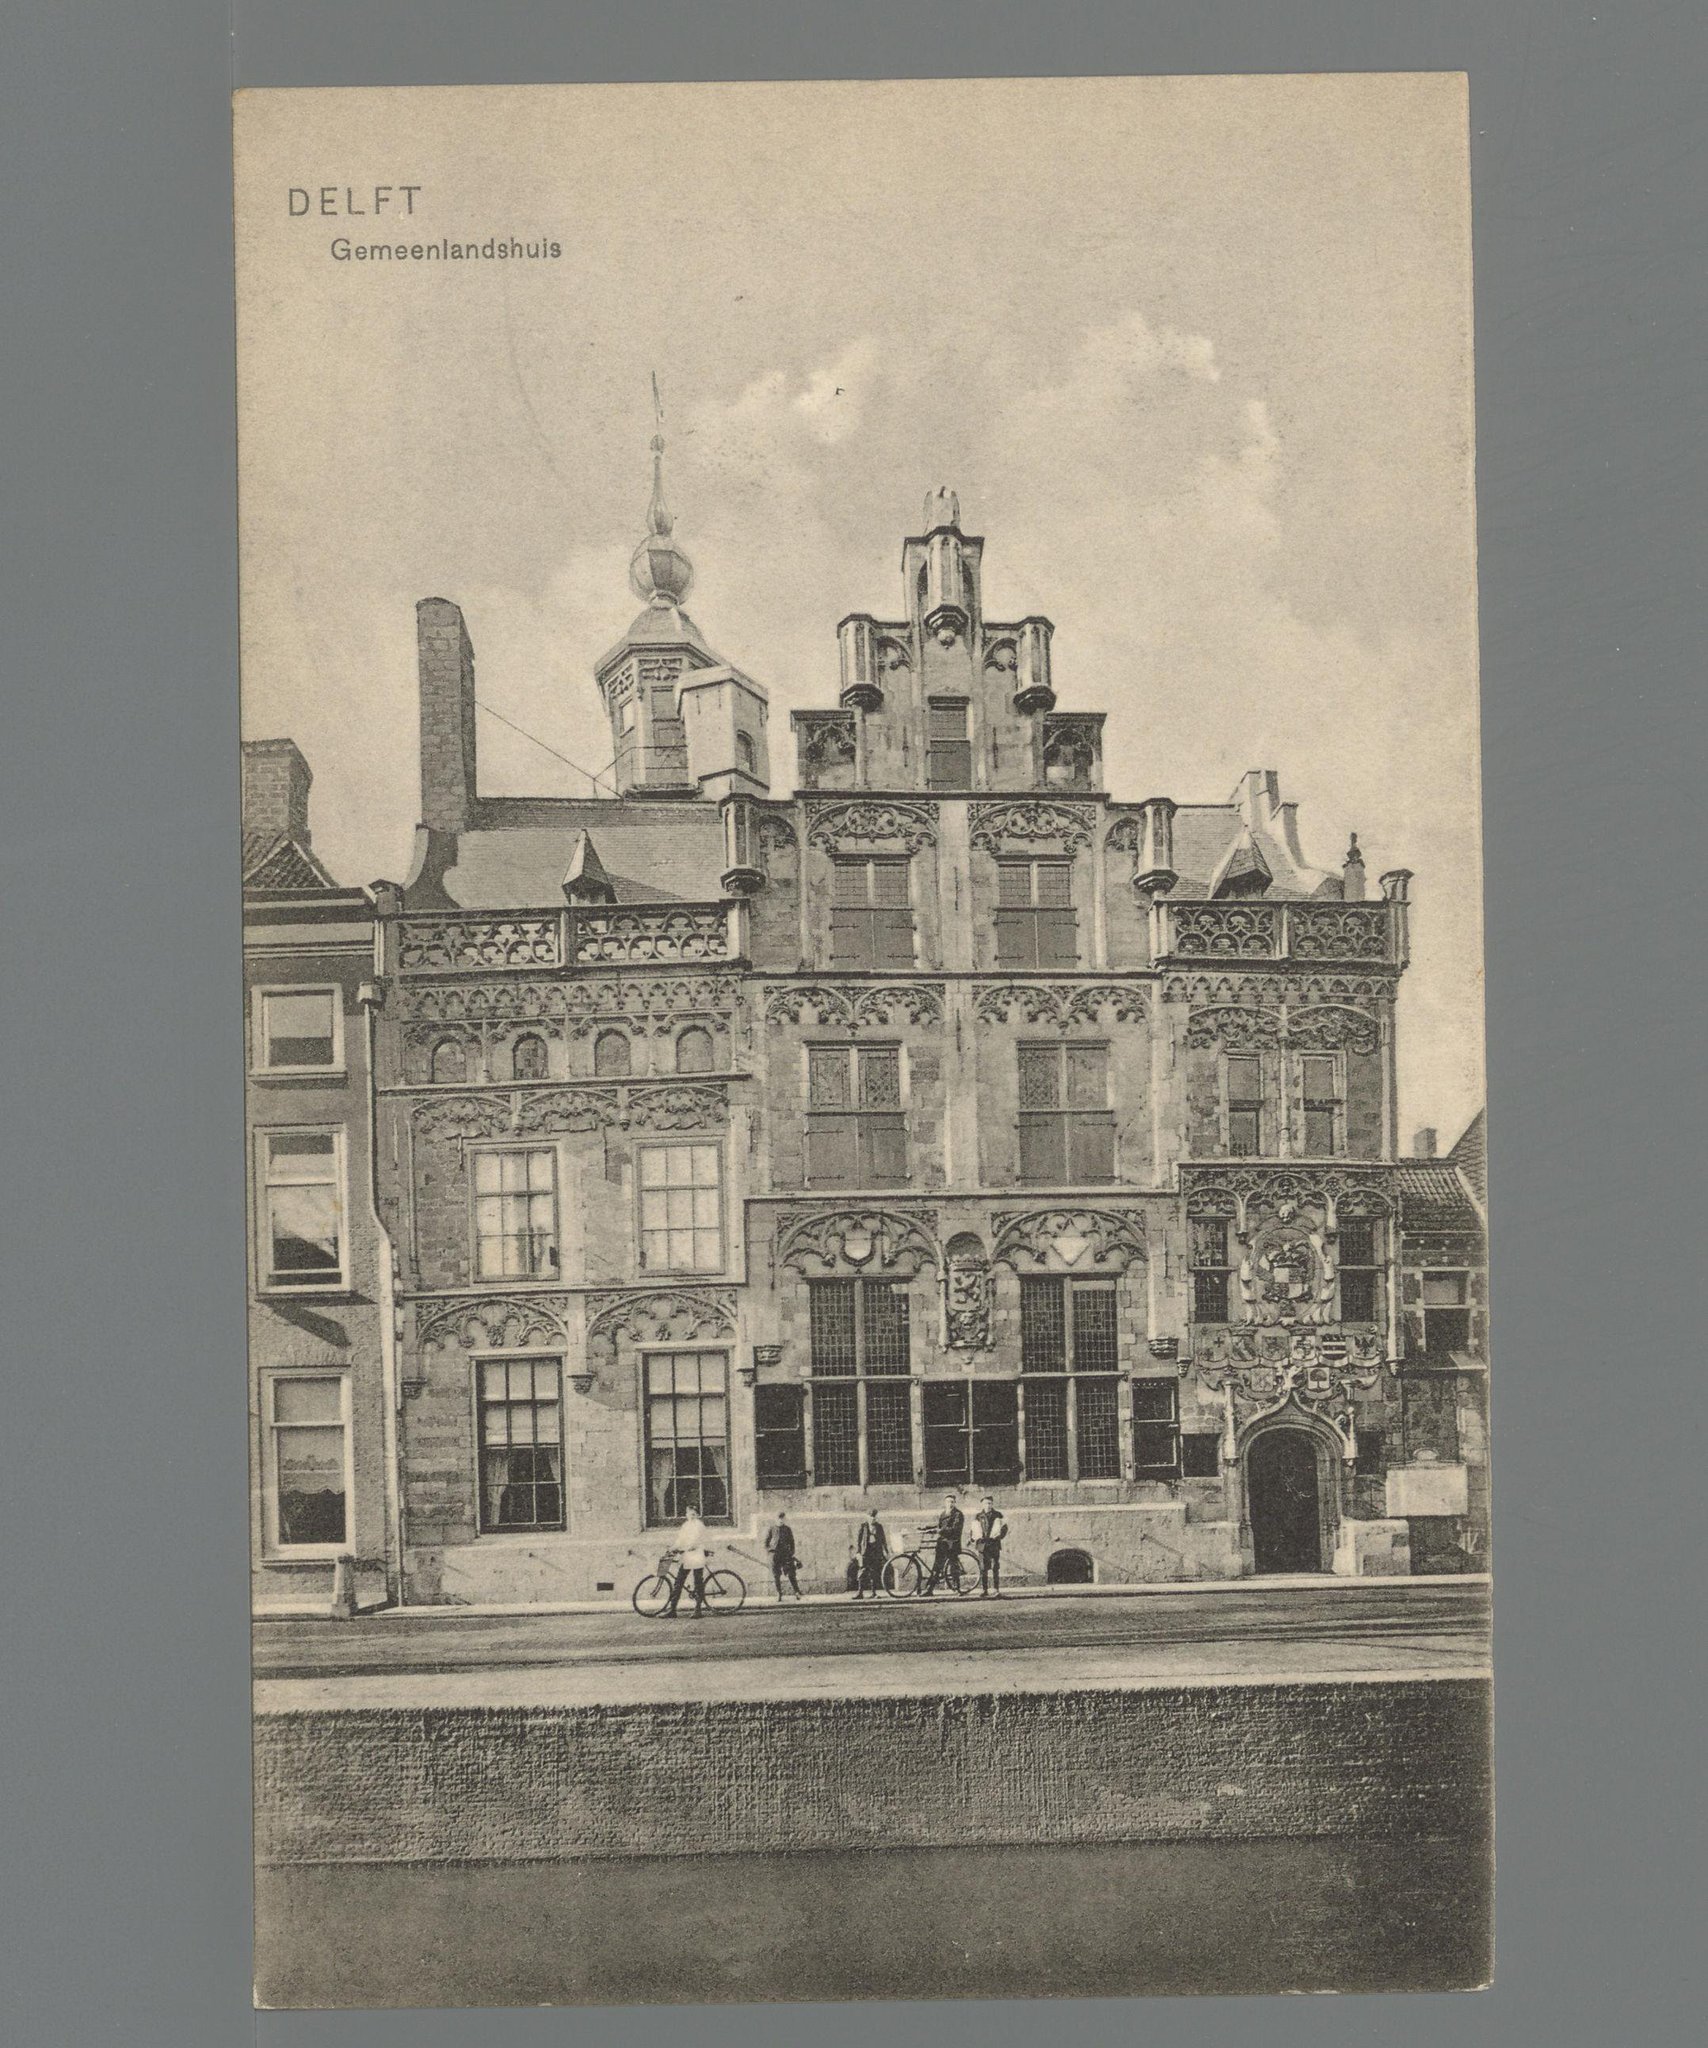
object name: photomechanical print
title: Delft. Gemeenlandshuis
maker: Anonymous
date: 1907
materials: cardboard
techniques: photograph, writing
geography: leipzig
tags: façade (of house or building)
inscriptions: postage stamp